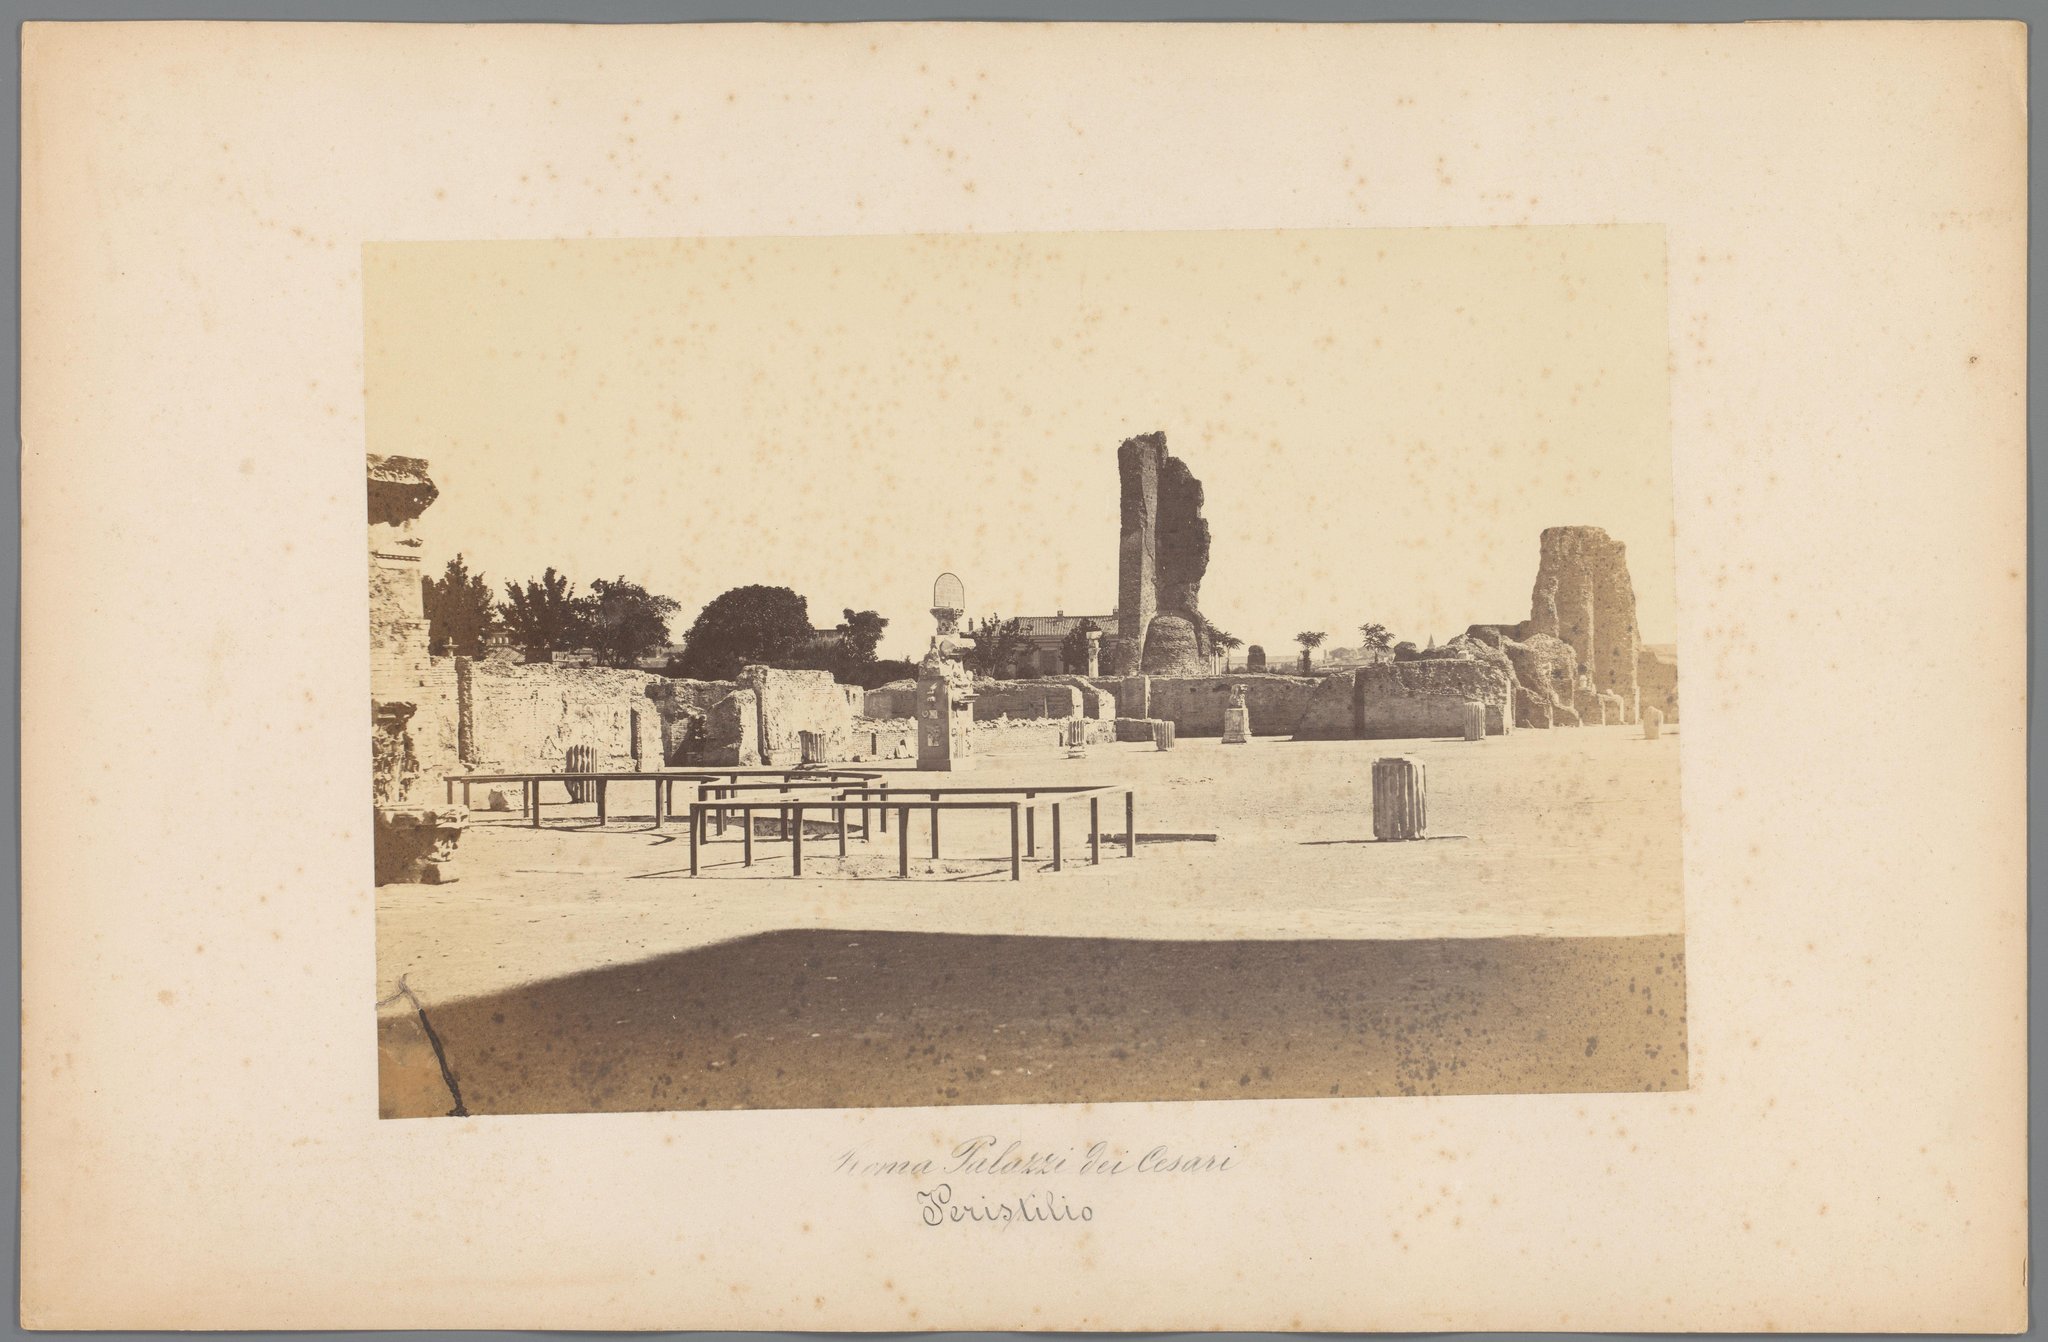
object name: photograph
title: Ruïnes op de Palatijn te Rome, Italië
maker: Anonymous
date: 1851-1900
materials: cardboard, paper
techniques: albumen print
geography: rome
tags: palace, landscape with ruins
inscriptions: inscription: ‘fr 2,50’, inscription: ‘Geristilio [?]’